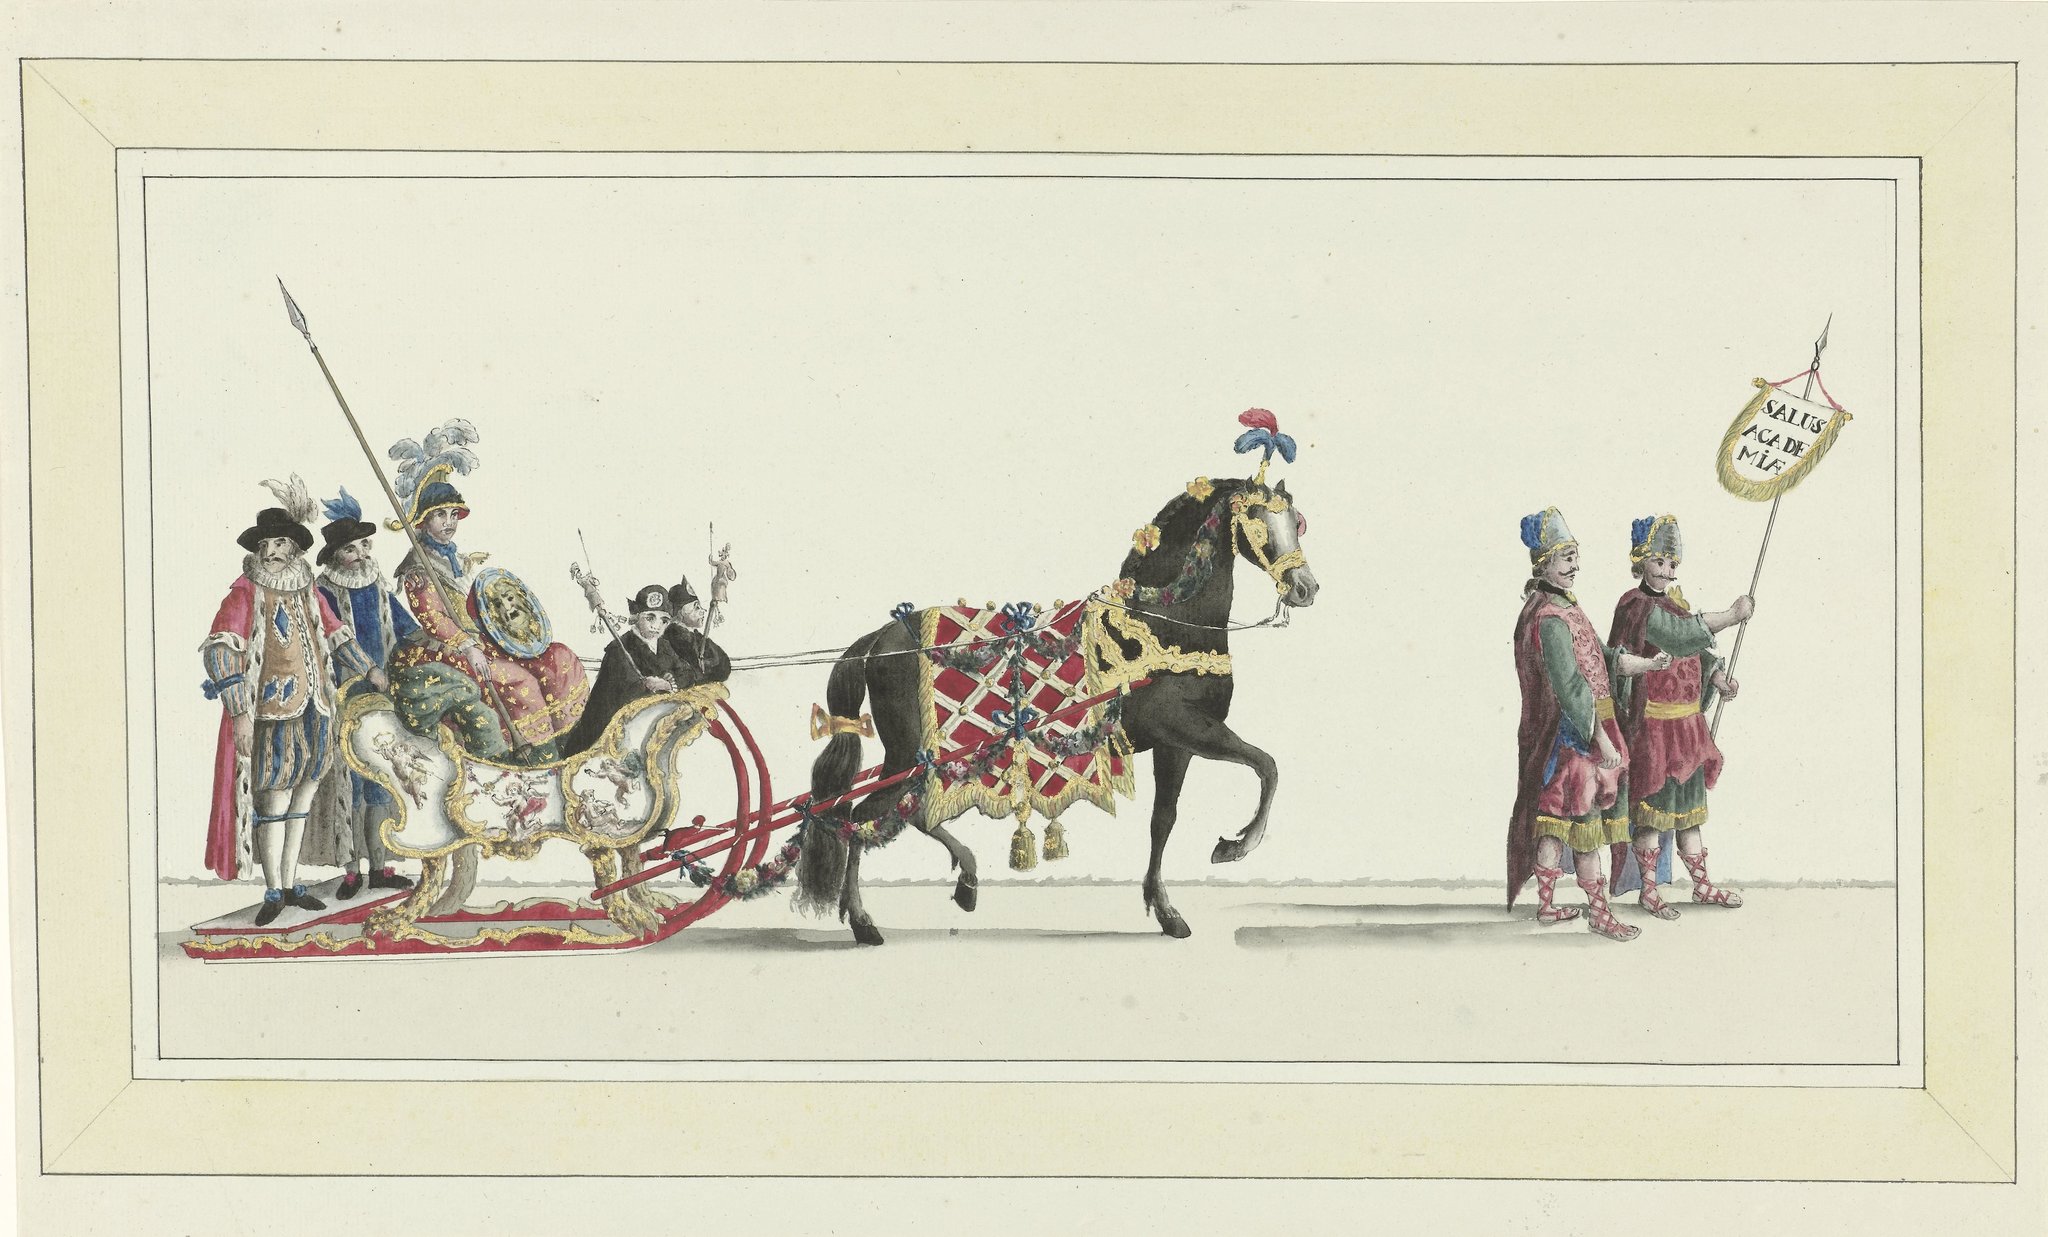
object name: drawing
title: Zevende slede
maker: abraham delfos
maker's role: draughtsman, painter, print maker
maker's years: 1731-1820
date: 1776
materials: paper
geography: northern netherlands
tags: sledge, sleigh (winter sports), commemoration of the founding of a university, leiden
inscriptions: collector's mark: Lugt 2228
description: De zevende slede in de optocht. Een slede met Minerva getrokken door een paard en voorafgegaan door twee personen in Griekse kleding. Onderdeel van de reeks van vijftien tekeningen voor de platen van de sledevaart op 24 januari 1776 georganiseerd door het Leidse genootschap Veniam Pro Laude bij gelegenheid van het Tweede Eeuwfeest van het Leids Ontzet (3 oktober 1574) en de oprichting van de Universiteit van Leiden (8 februari 1575).